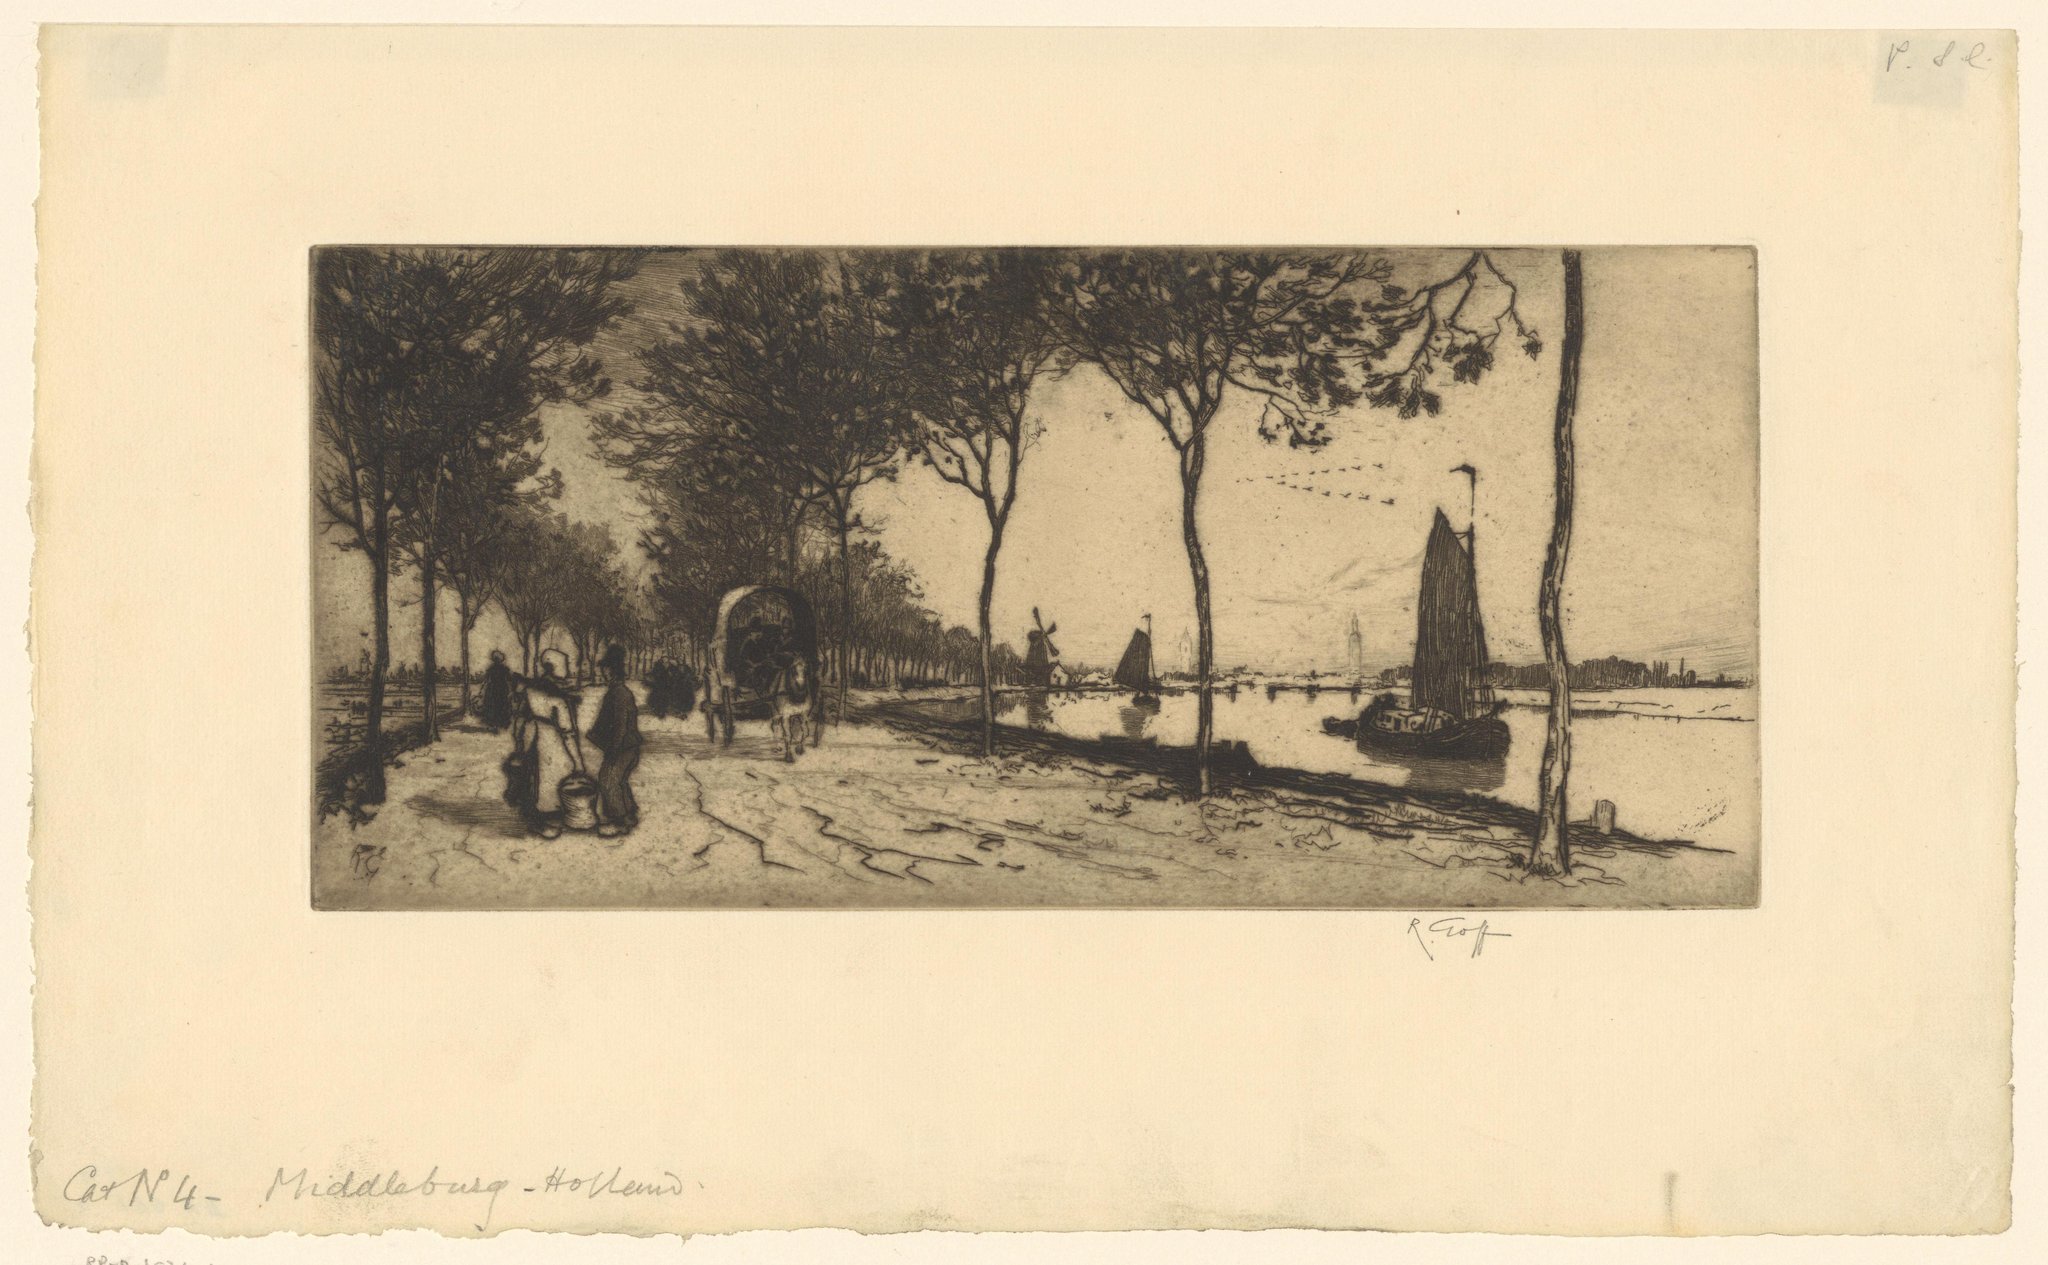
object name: print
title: Gezicht op Buitenhaven en Middelburg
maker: robert charles goff (1837-1922)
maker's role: painter, print maker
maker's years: 1837-1922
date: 1878-1922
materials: paper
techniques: drypoint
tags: water course, prospect of city, town panorama, silhouette of city (+ city(-scape) with figures, staffage)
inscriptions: collector's mark: Lugt 4731, collector's mark: Lugt 2228, watermark: